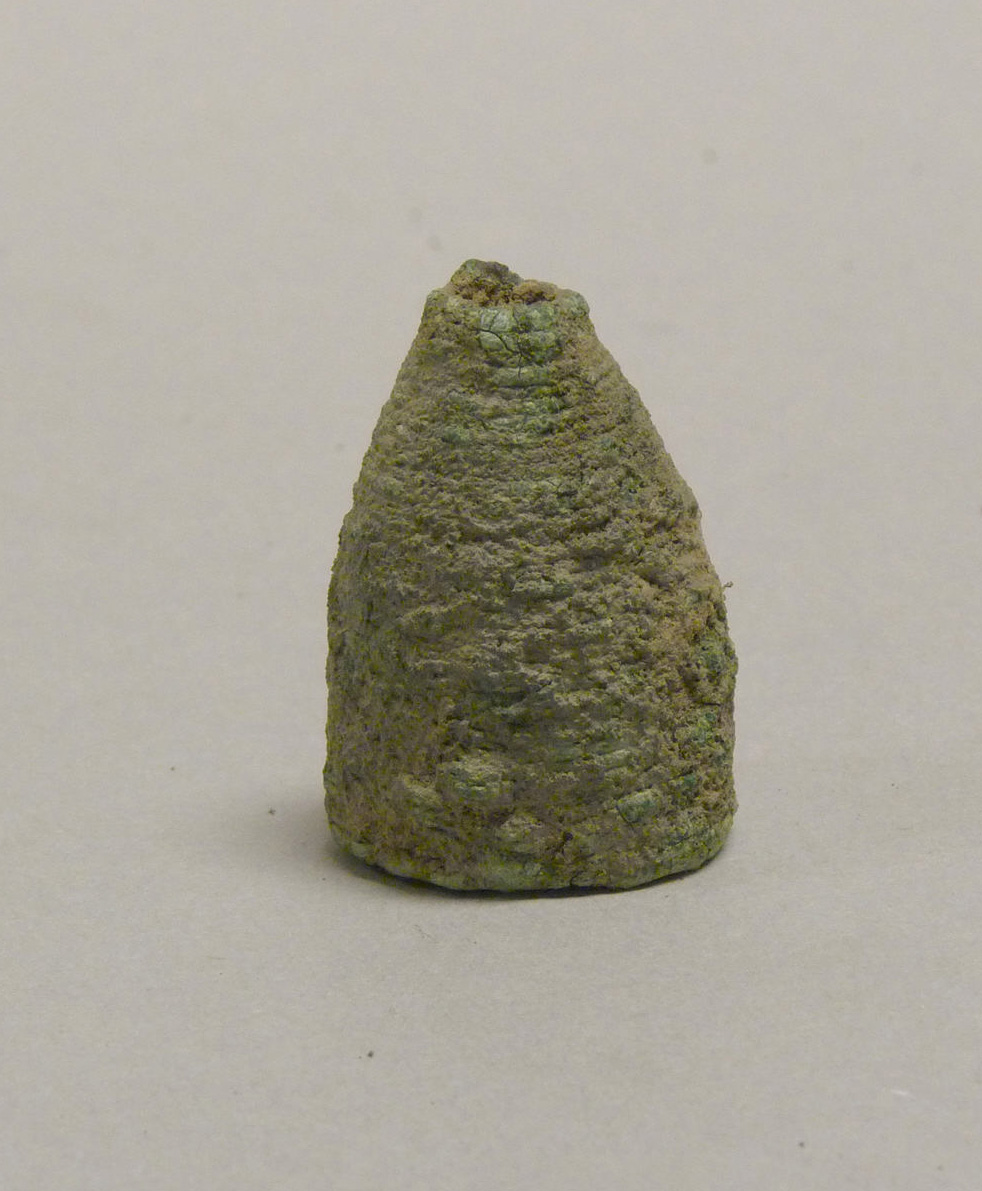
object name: bell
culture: thai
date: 500 BCE-300 CE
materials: bronze